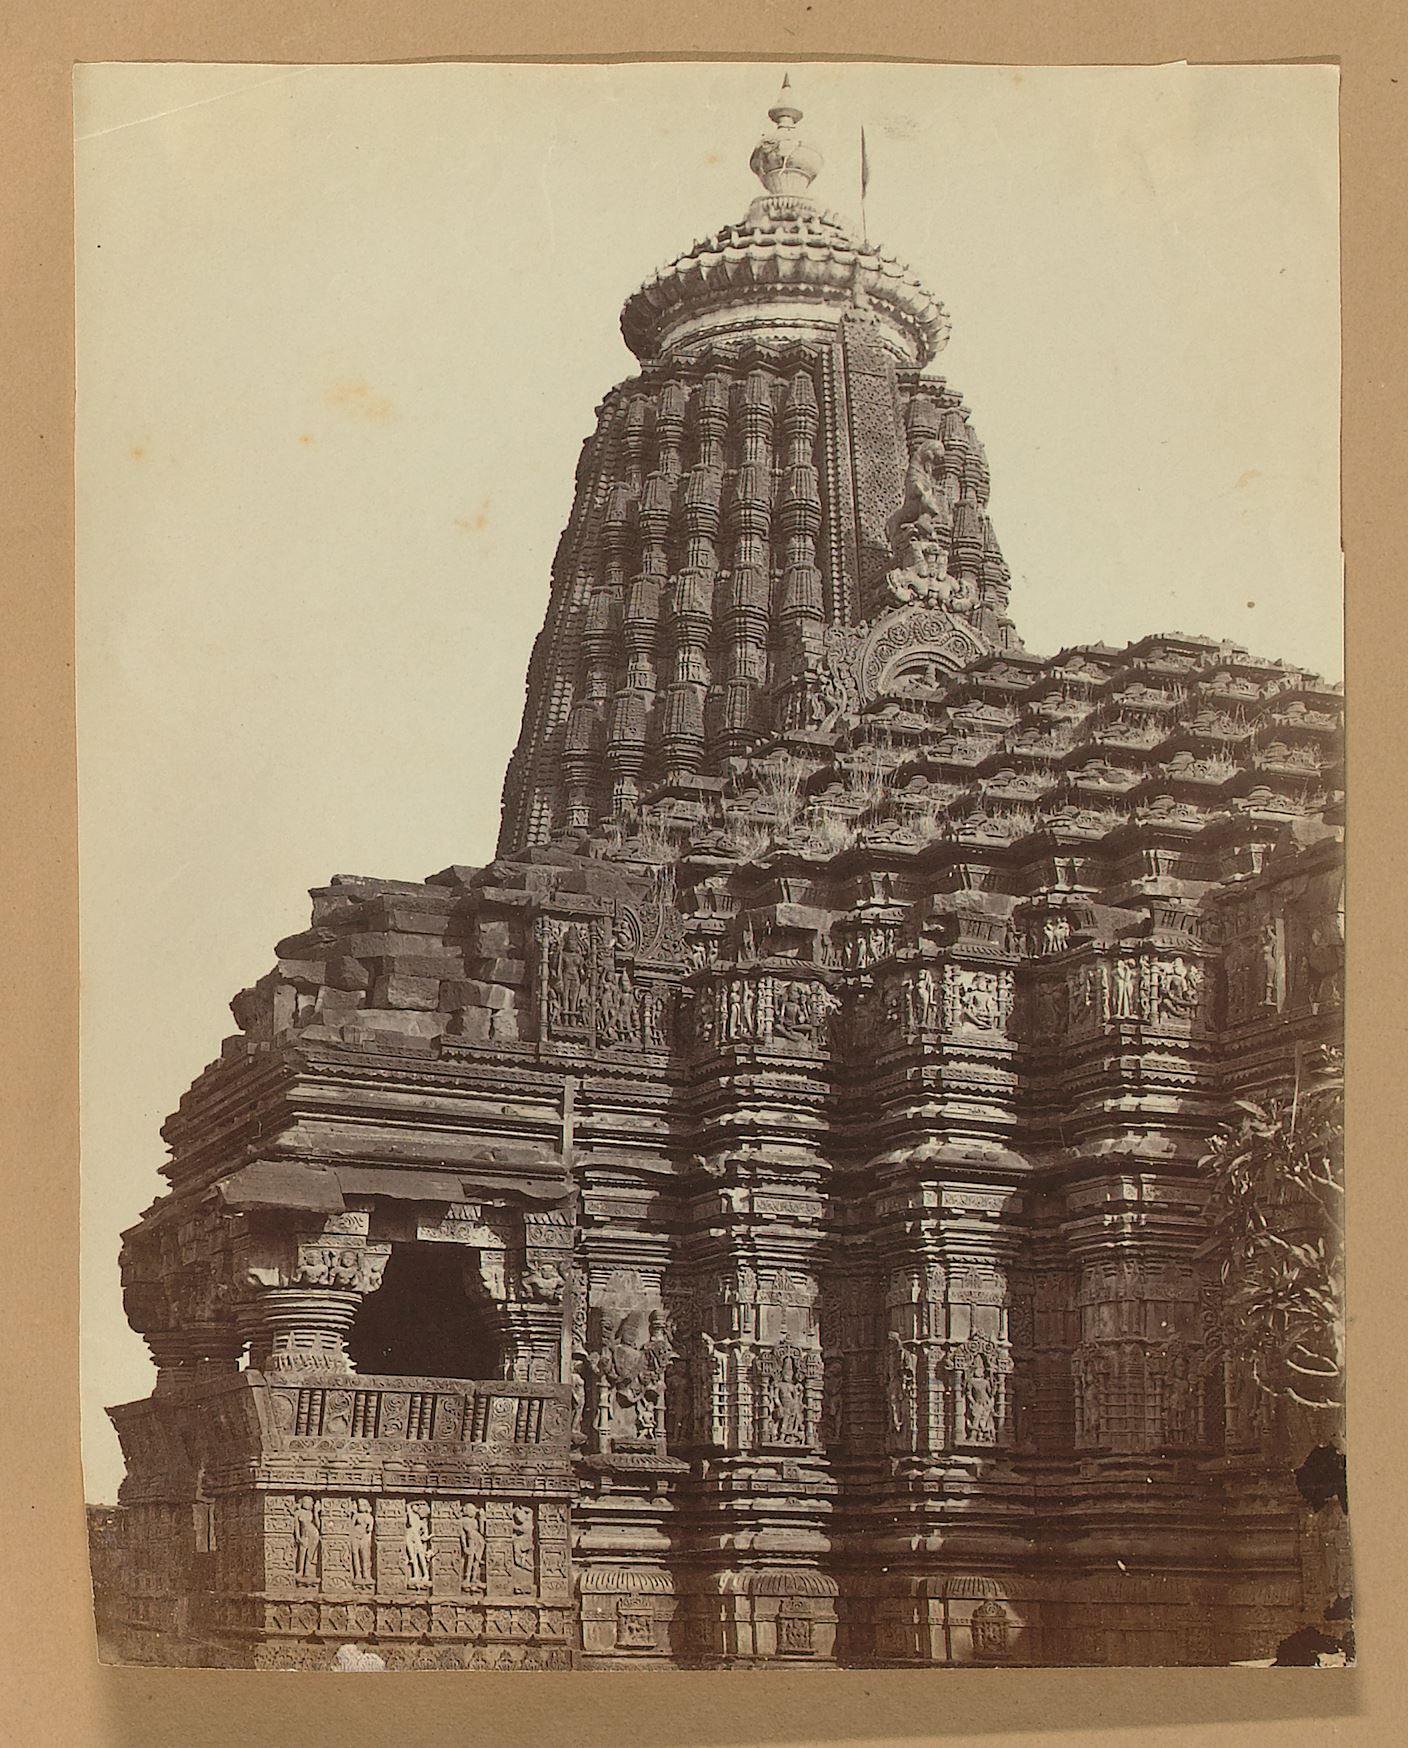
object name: photograph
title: India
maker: james john waterhouse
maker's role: fotograaf, luitenant, officier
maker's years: 1842-1928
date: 1860-1865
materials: cardboard, paper, photographic support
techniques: albumen print